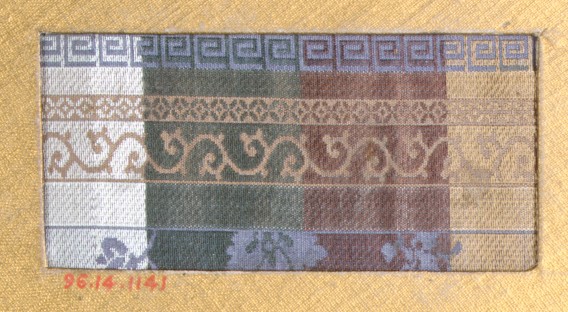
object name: piece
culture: japanese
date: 1701-1900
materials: silk